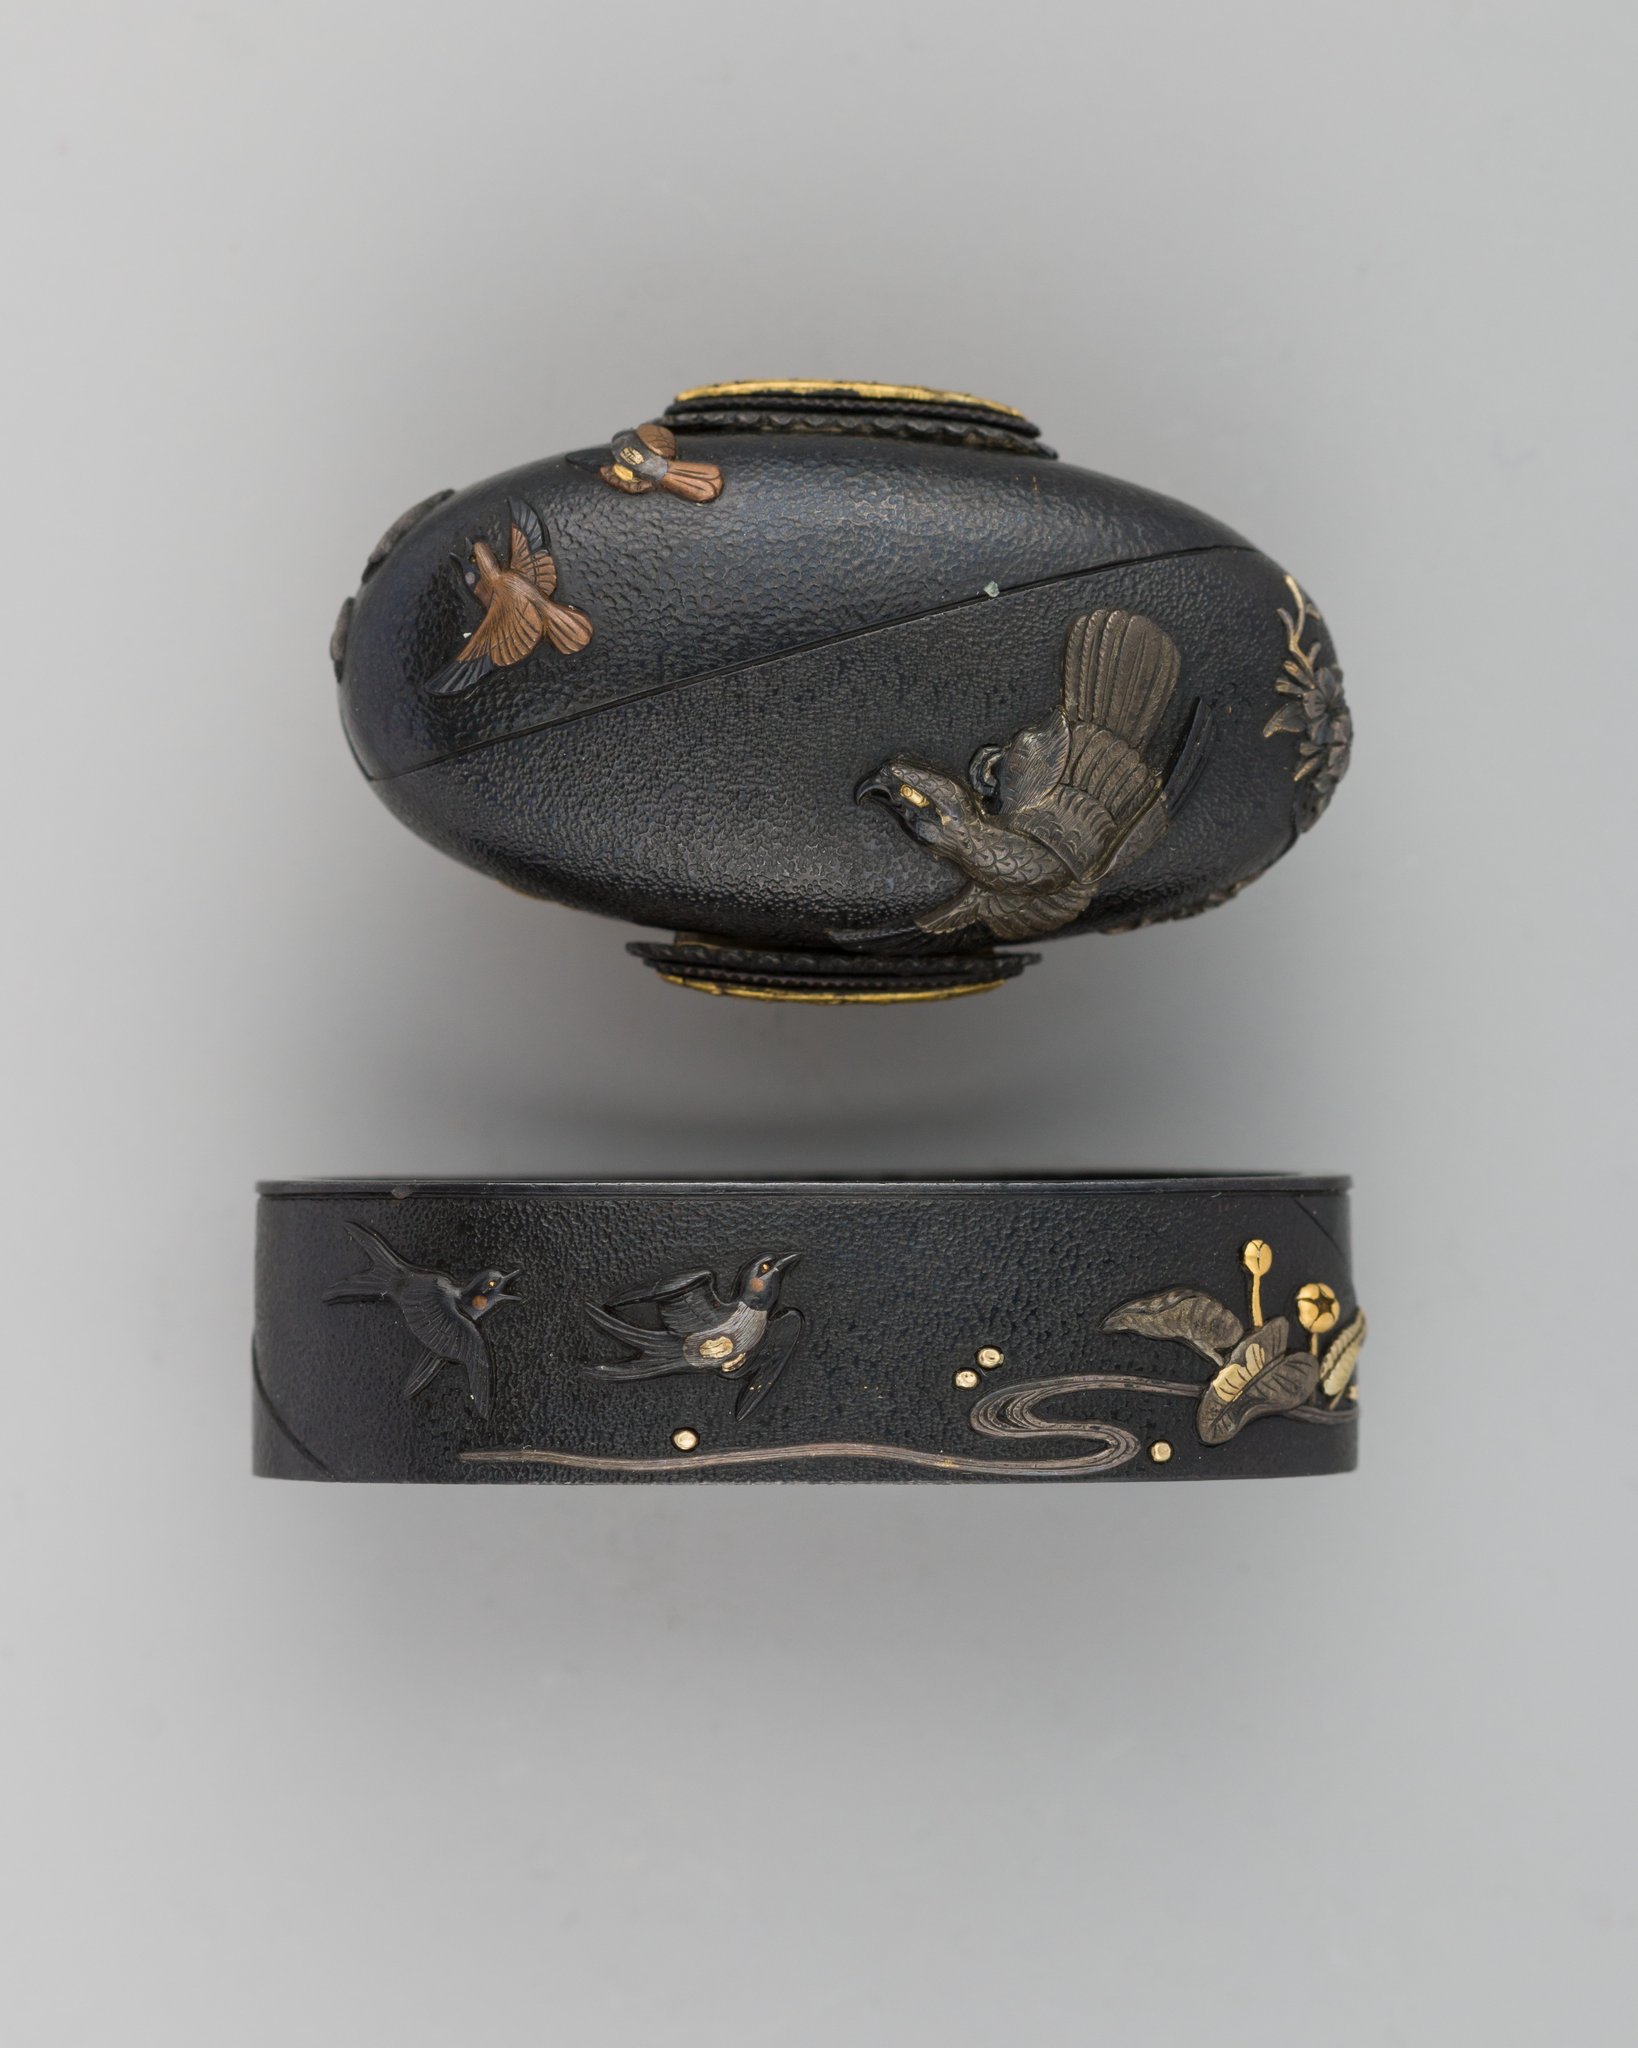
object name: sword hilt collar and pommel fuchigashira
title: Sword-Hilt Collar and Pommel (Fuchigashira)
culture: japanese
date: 1701-1800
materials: copper, gold alloy, silver alloy, gold, silver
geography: japan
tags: birds